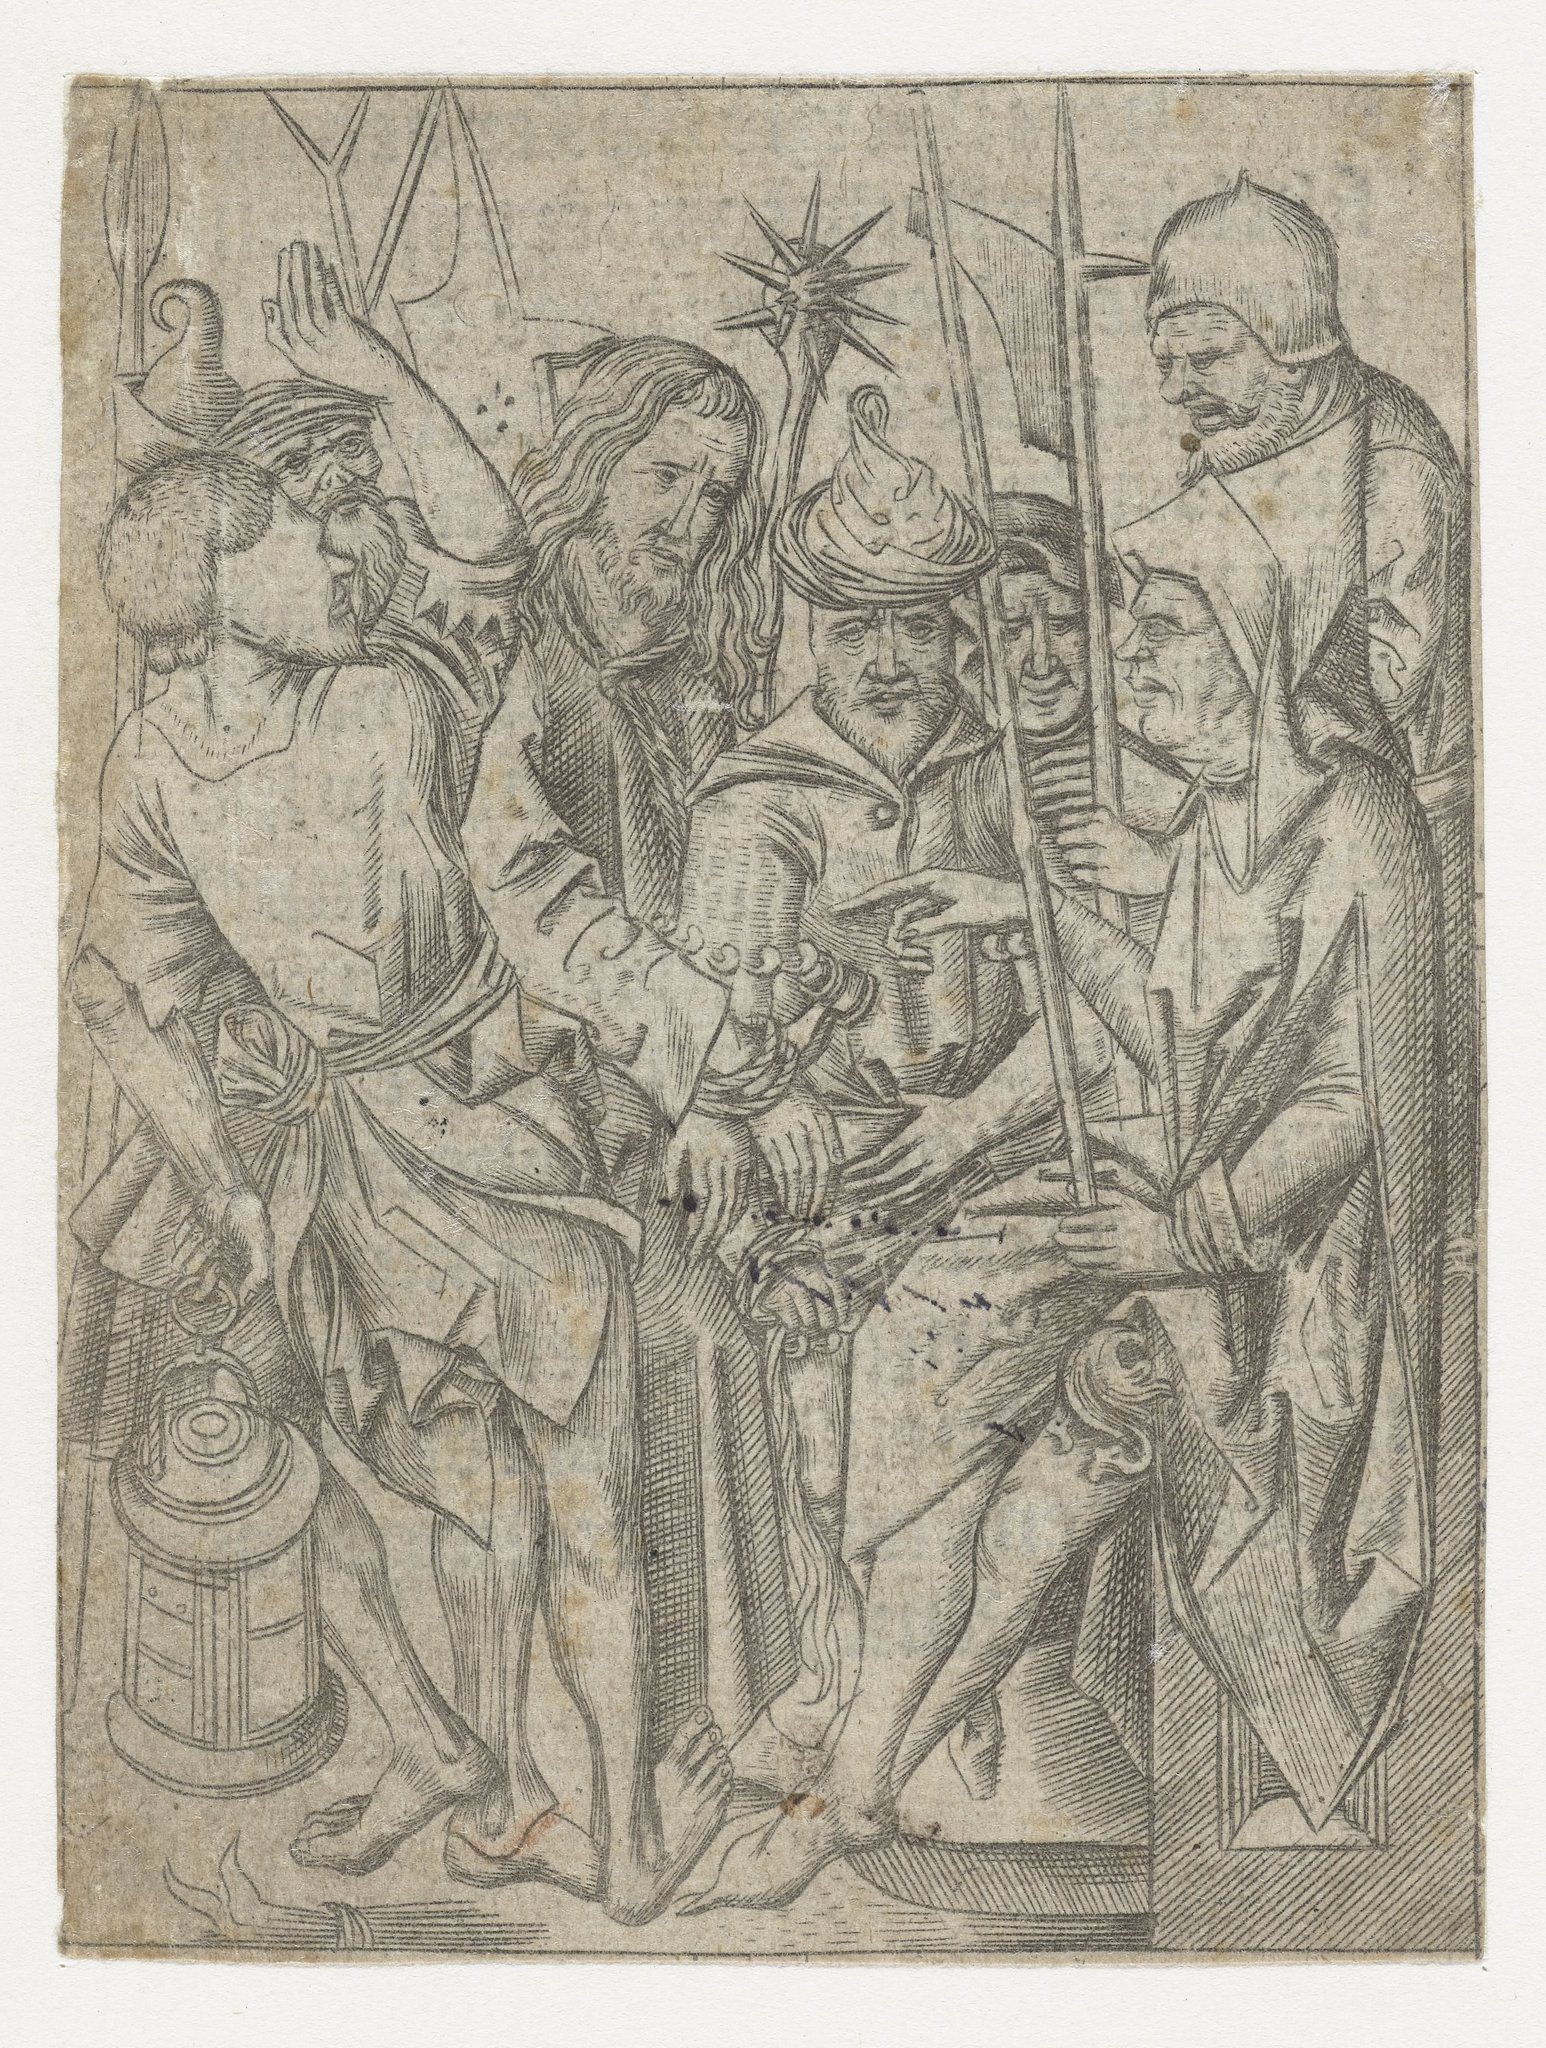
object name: print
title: Christus voor Annas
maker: Anonymous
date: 1500-1550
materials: paper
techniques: engraving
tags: christ before annas (hanna); maybe a soldier about to strike christ (john 18:13, 18:19-24)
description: Christus staat, gebonden aan hals en handen en omringd door gewapende mannen, voor een man op een troon (Annas). Op versozijde een deel van een handgeschreven Nederlandse tekst in gotisch schrift.